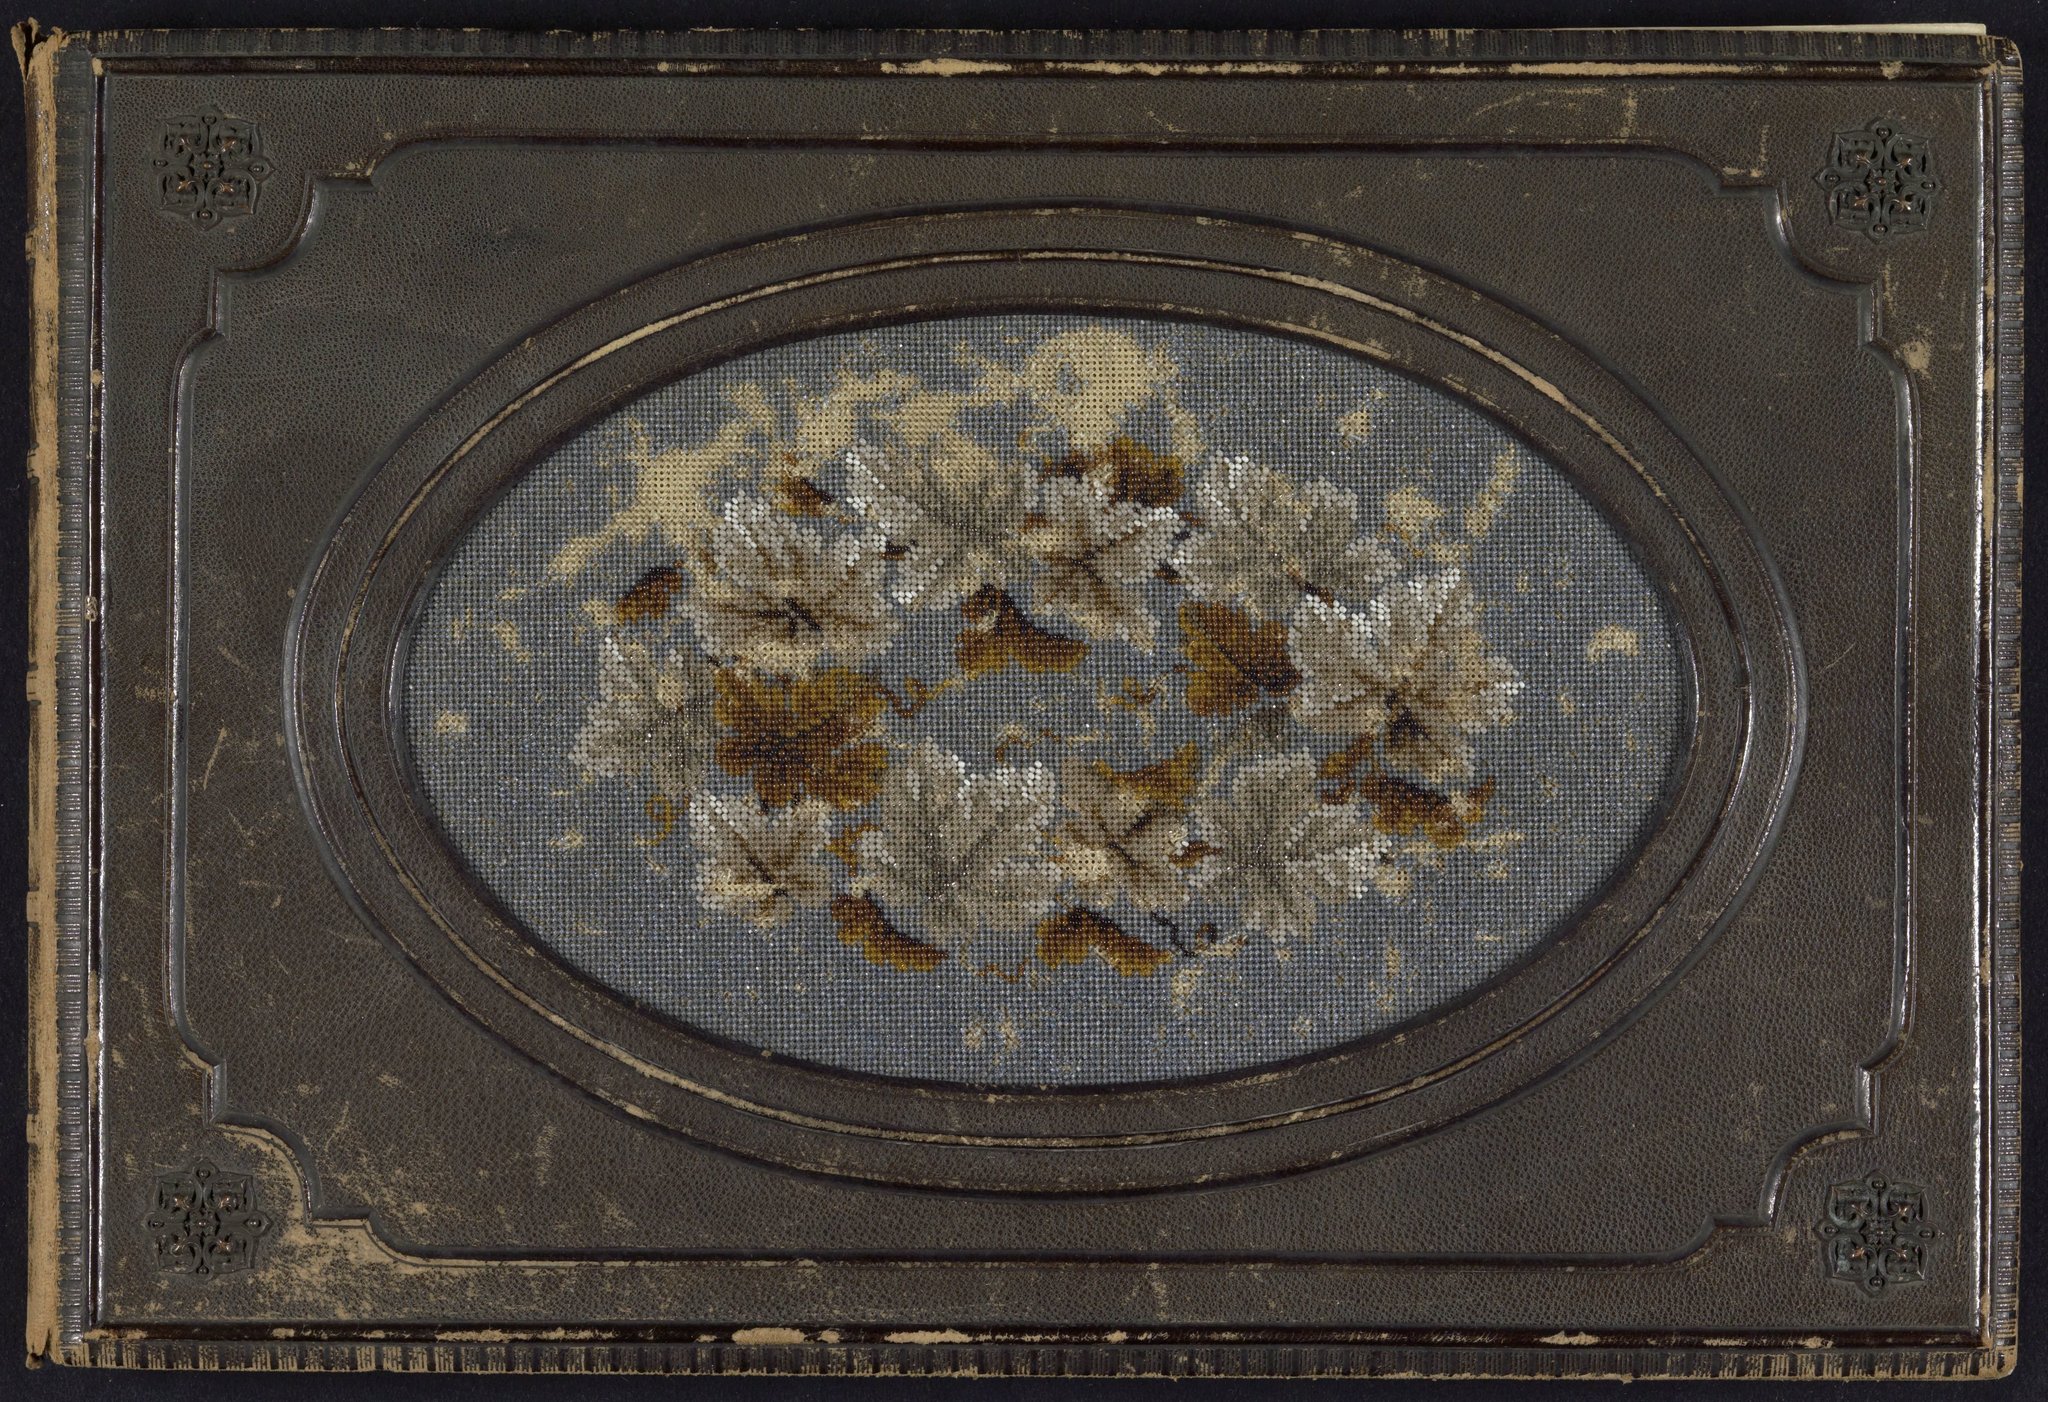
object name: photograph album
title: Reisalbum met opnames van bezienswaardigheden in India, Duitsland, Zwitserland en Frankrijk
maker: Anonymous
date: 1860-1900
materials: cardboard, copper, glass, leather, paper, photographic support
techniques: albumen print, embroidered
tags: travelling; tourism, germany, france, switzerland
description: Fotoalbum in leren band. Voor- en achterplat zijn versierd met koperen knoppen en geometrische motieven in reliëf. Op het voorplat een voorstelling van bladeren gemaakt van kleine geborduurde kralen. De goud-op-snee albumbladen bevatten 59 opgeplakte foto's. Het zijn opnames gemaakt in India: stads- en straatgezichten, havens, kades, moskeeën, stadspoorten, Britse regeringsgebouwen en kerken. Daarnaast afdrukken van Duitse en Zwitserse stadsgezichten, van Alpenlandschappen en van bezienswaardigheden in Parijs.